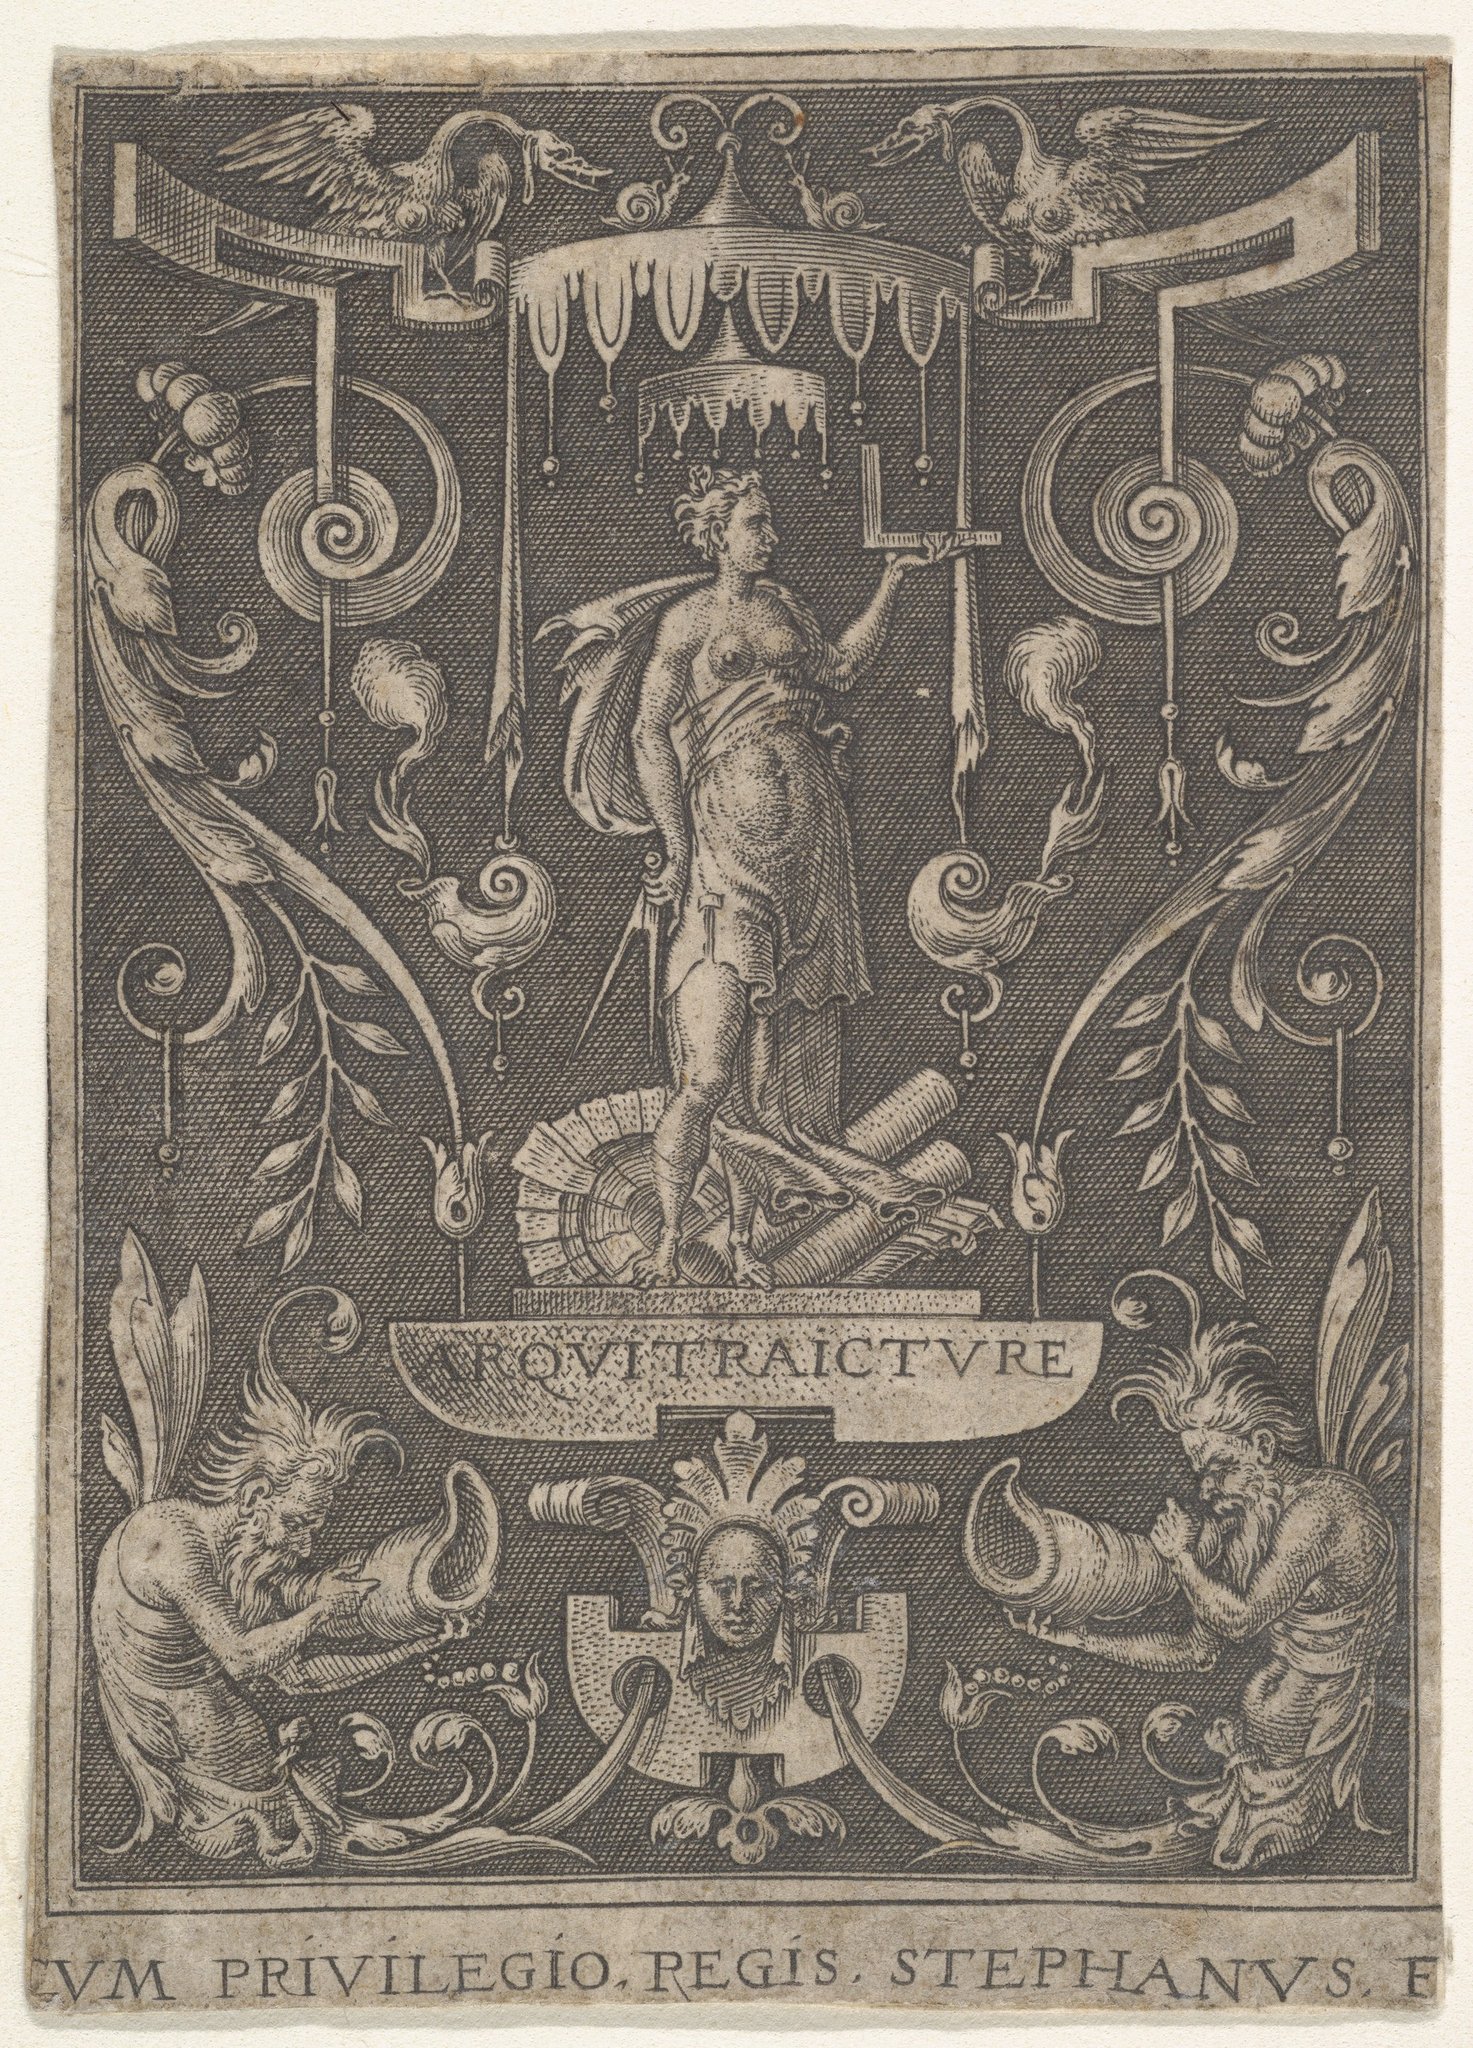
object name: print ornament architecture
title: Architecture (Arquitraicture)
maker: etienne delaune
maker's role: artist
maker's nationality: french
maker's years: 1518-1583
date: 1540-1583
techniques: engraving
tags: musical instruments,women